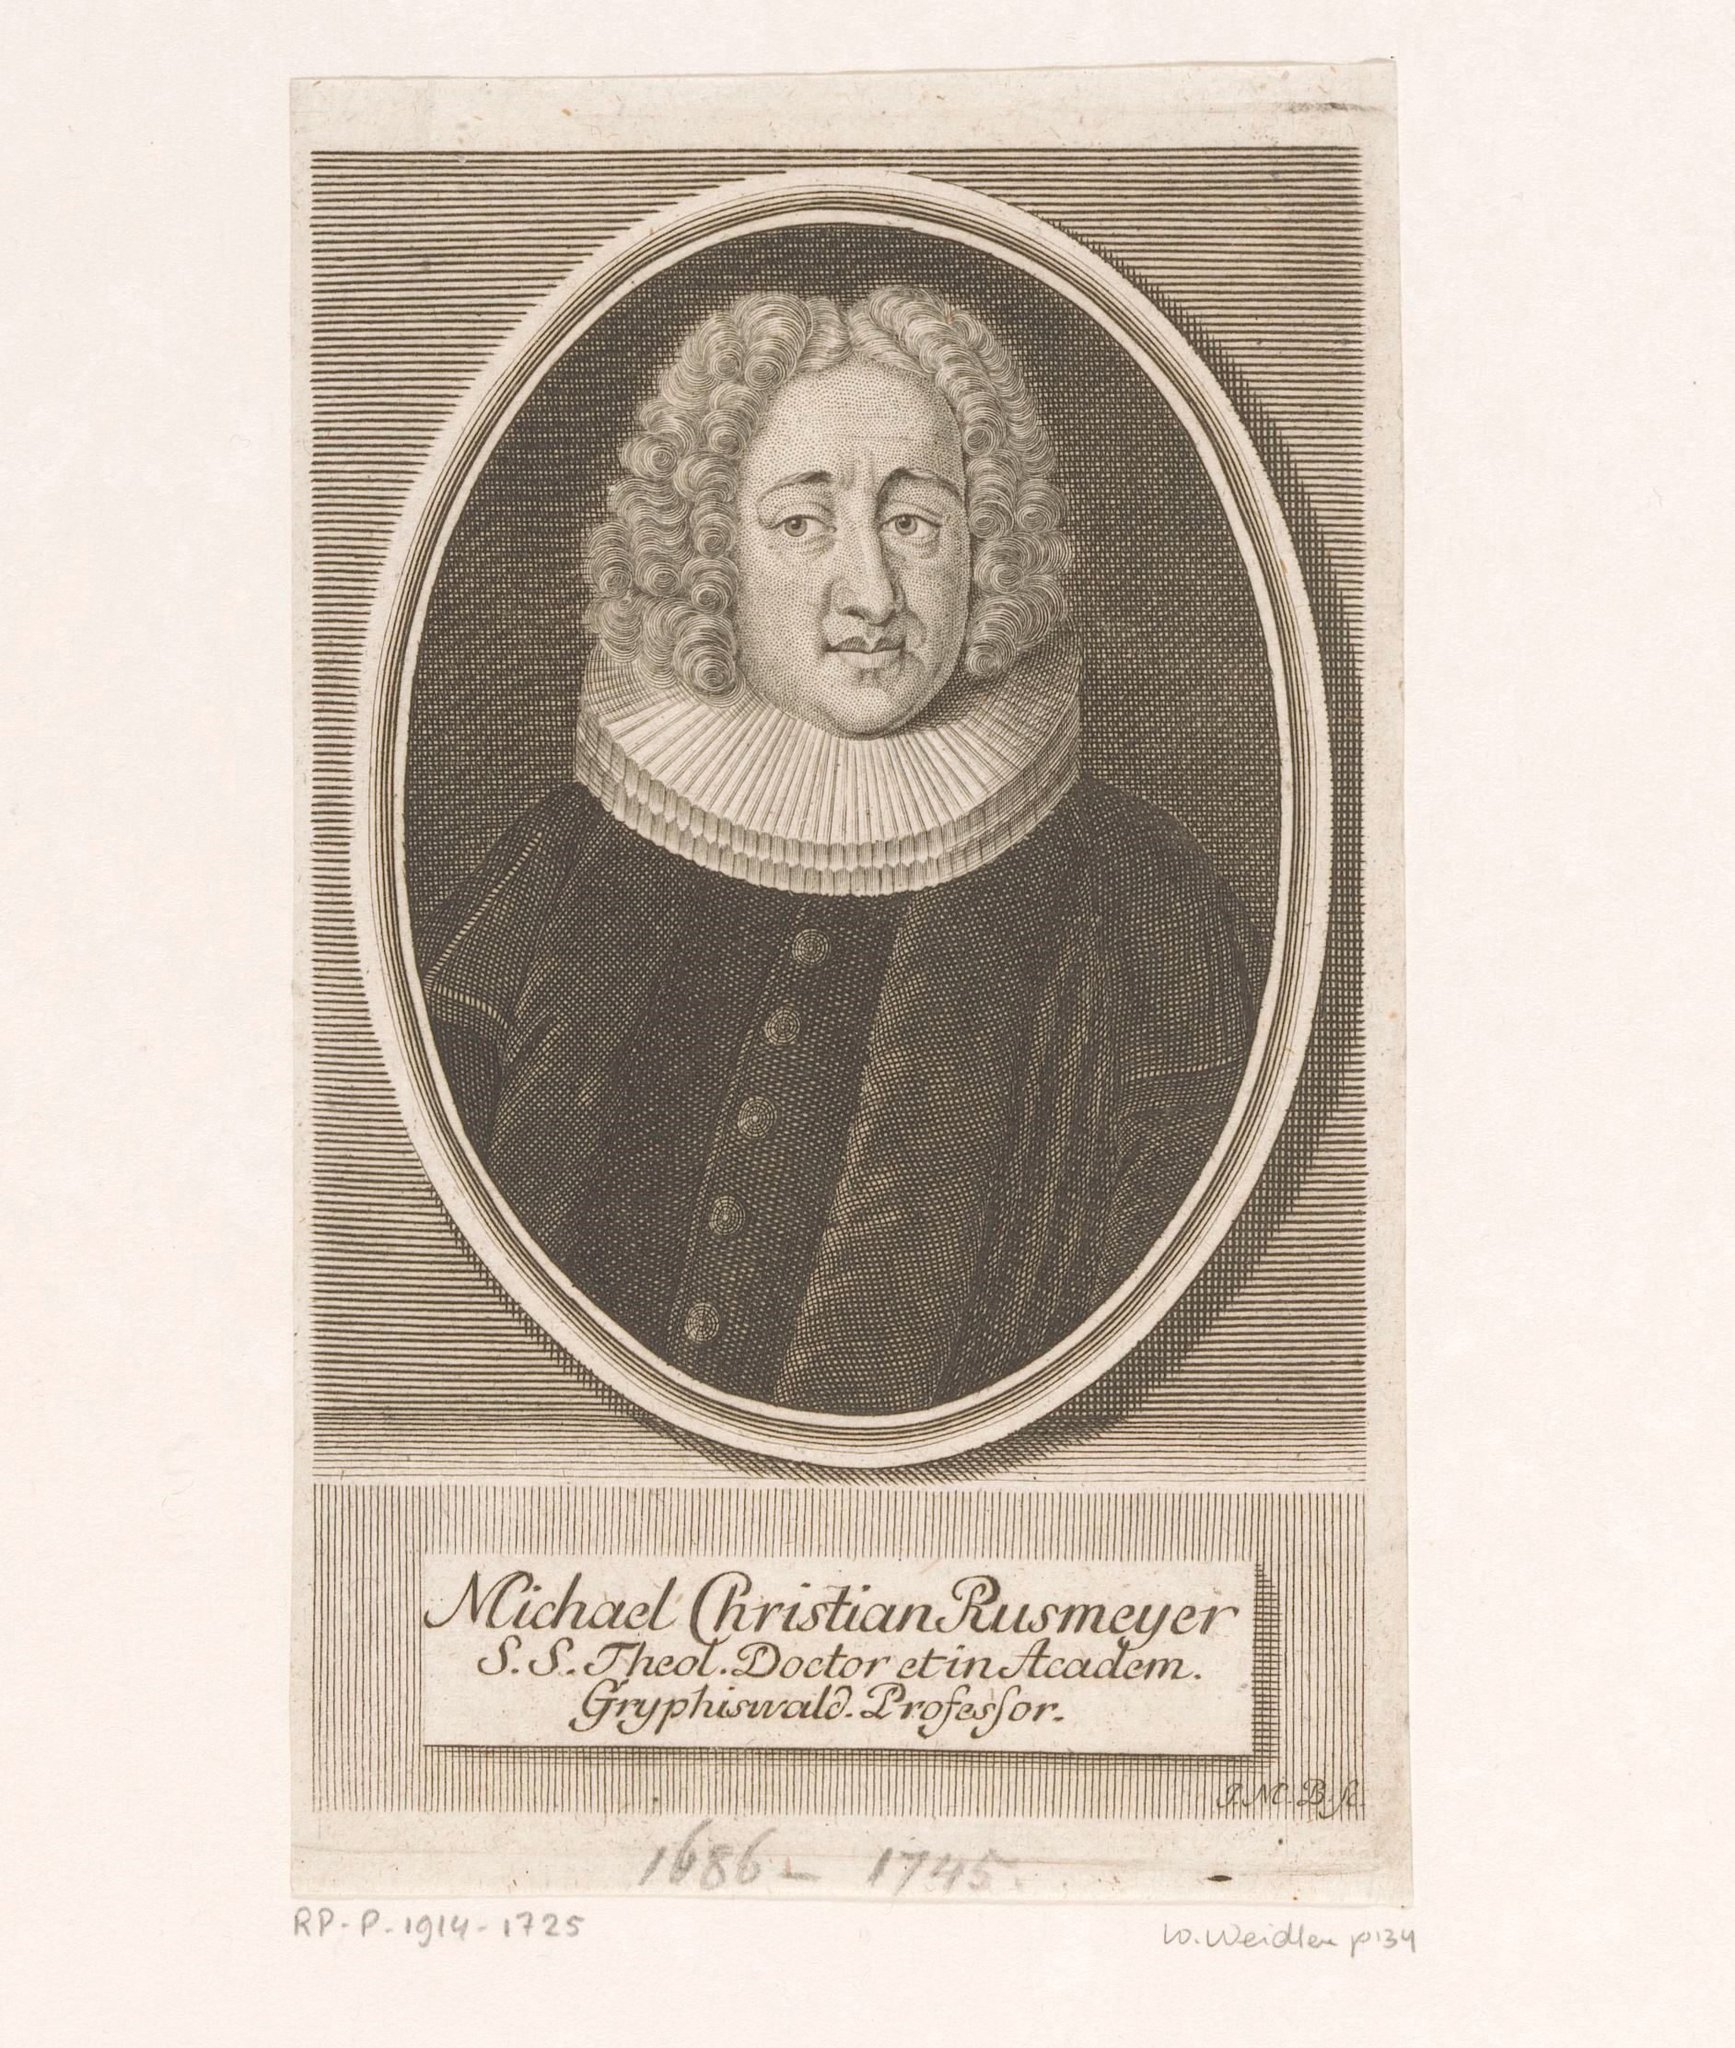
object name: print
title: Portret van Michael Christian Rusmeyer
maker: johann martin bernigeroth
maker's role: print maker, publisher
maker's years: 1713-1767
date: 1738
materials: paper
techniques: engraving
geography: leipzig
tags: historical persons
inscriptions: collector's mark: Lugt 2228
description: Prent ook gebruikt in: Deutsche Acta Eruditorum (...). dl. 228. Leipzig: Johann Gottlieb Gleditsch, 1738.